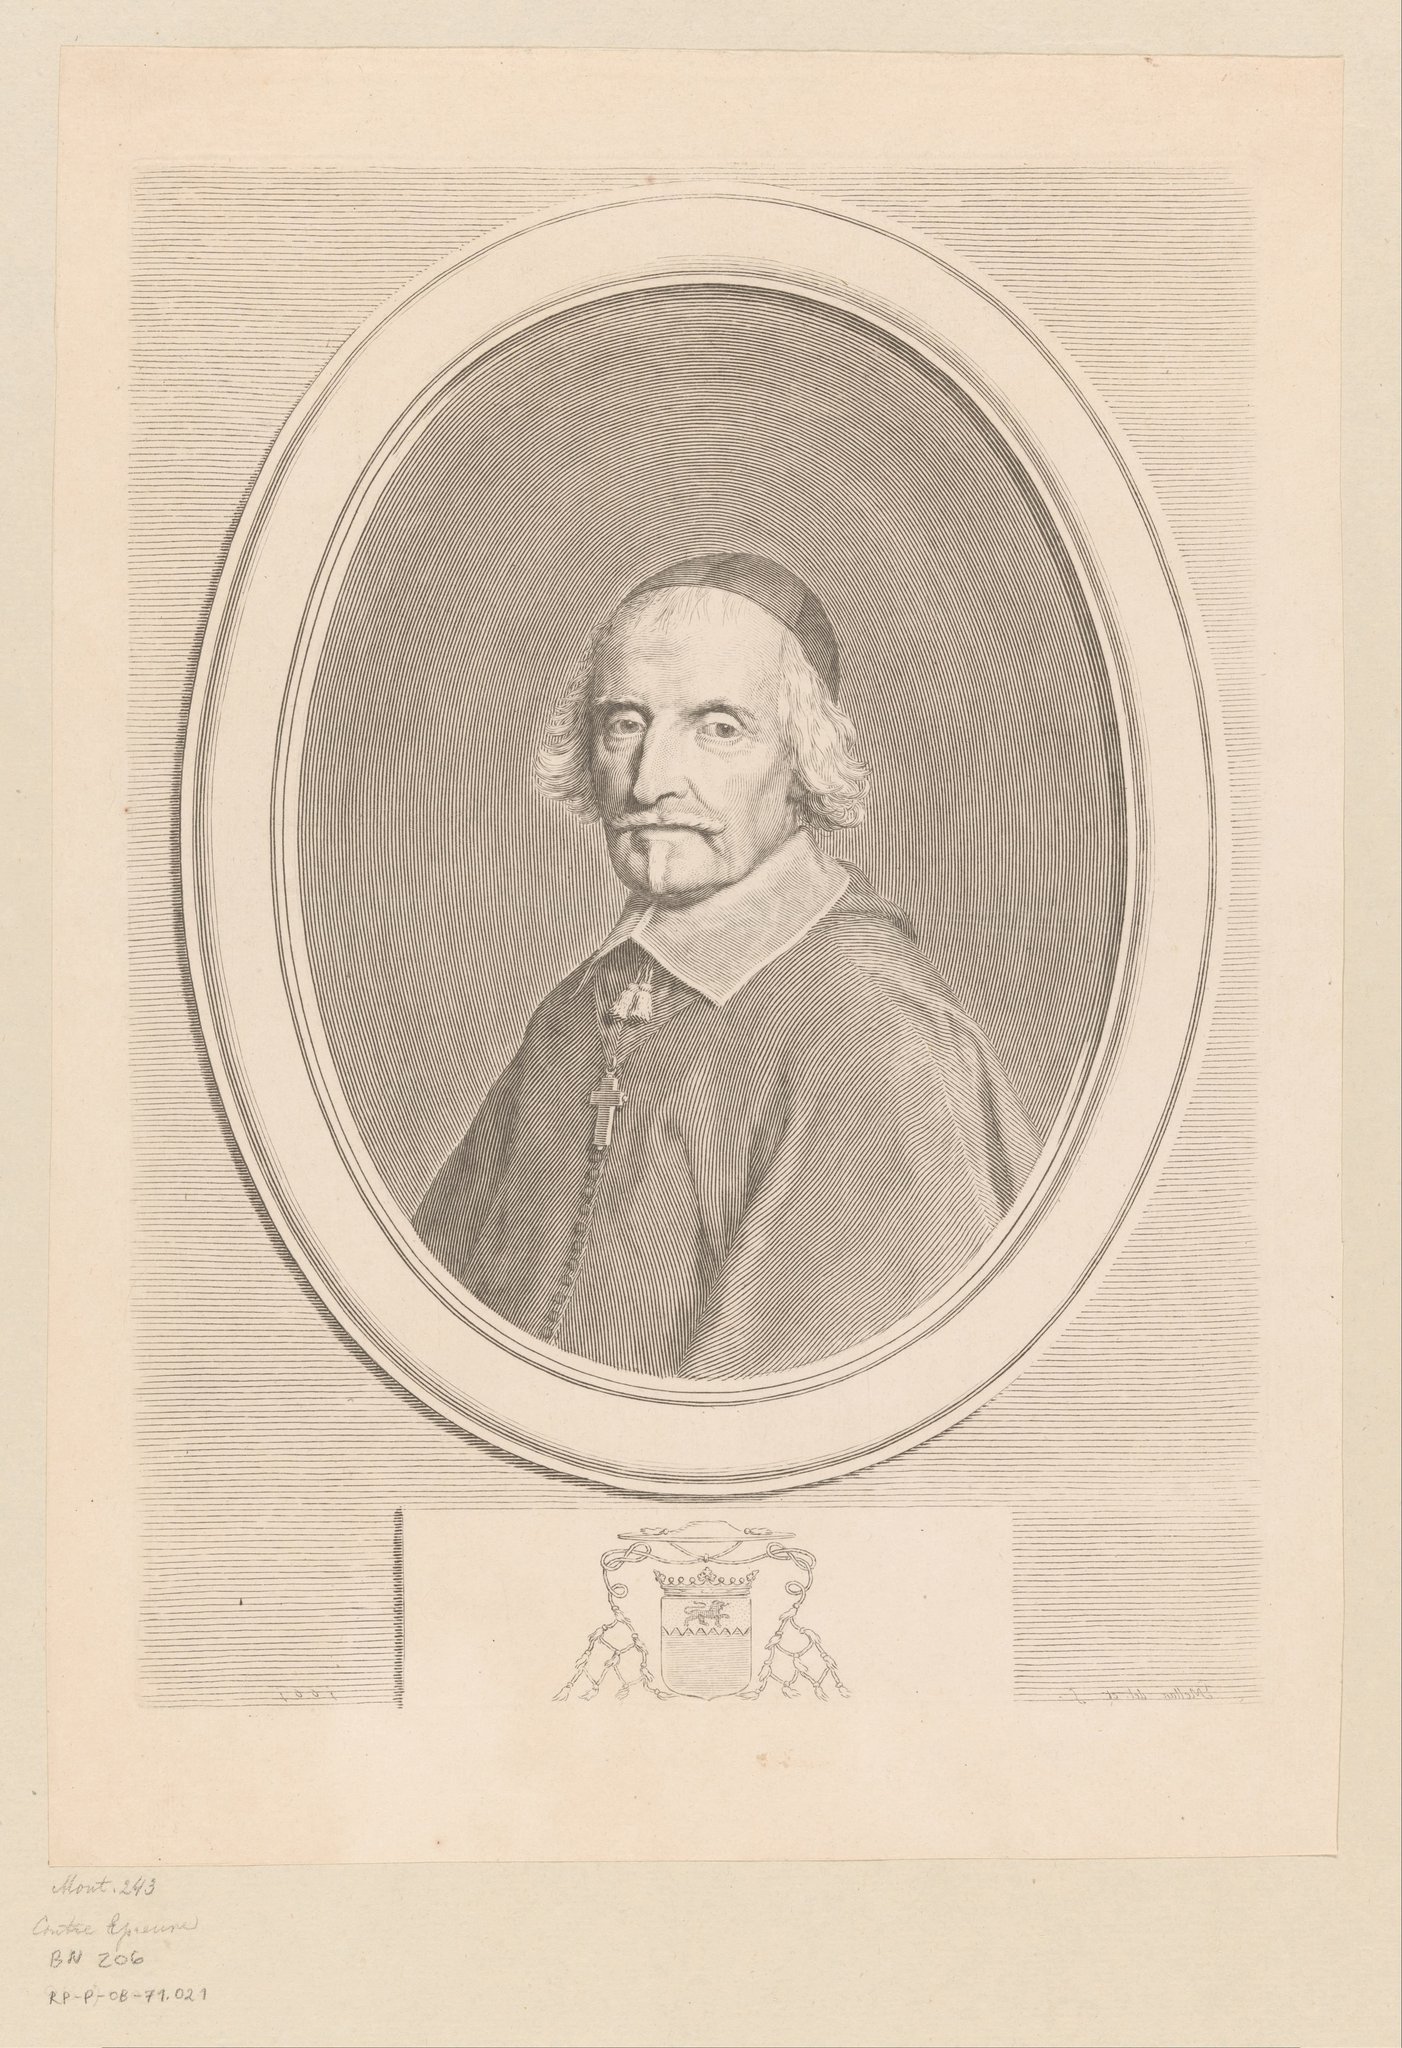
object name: print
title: Portret van François de Villemontée, bisschop van Saint-Malo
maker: claude mellan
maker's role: draughtsman, print maker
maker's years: 1598-1688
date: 1661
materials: paper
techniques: printmaking, engraving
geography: france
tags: paris, historical persons, armorial bearing, heraldry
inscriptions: collector's mark: Lugt 240